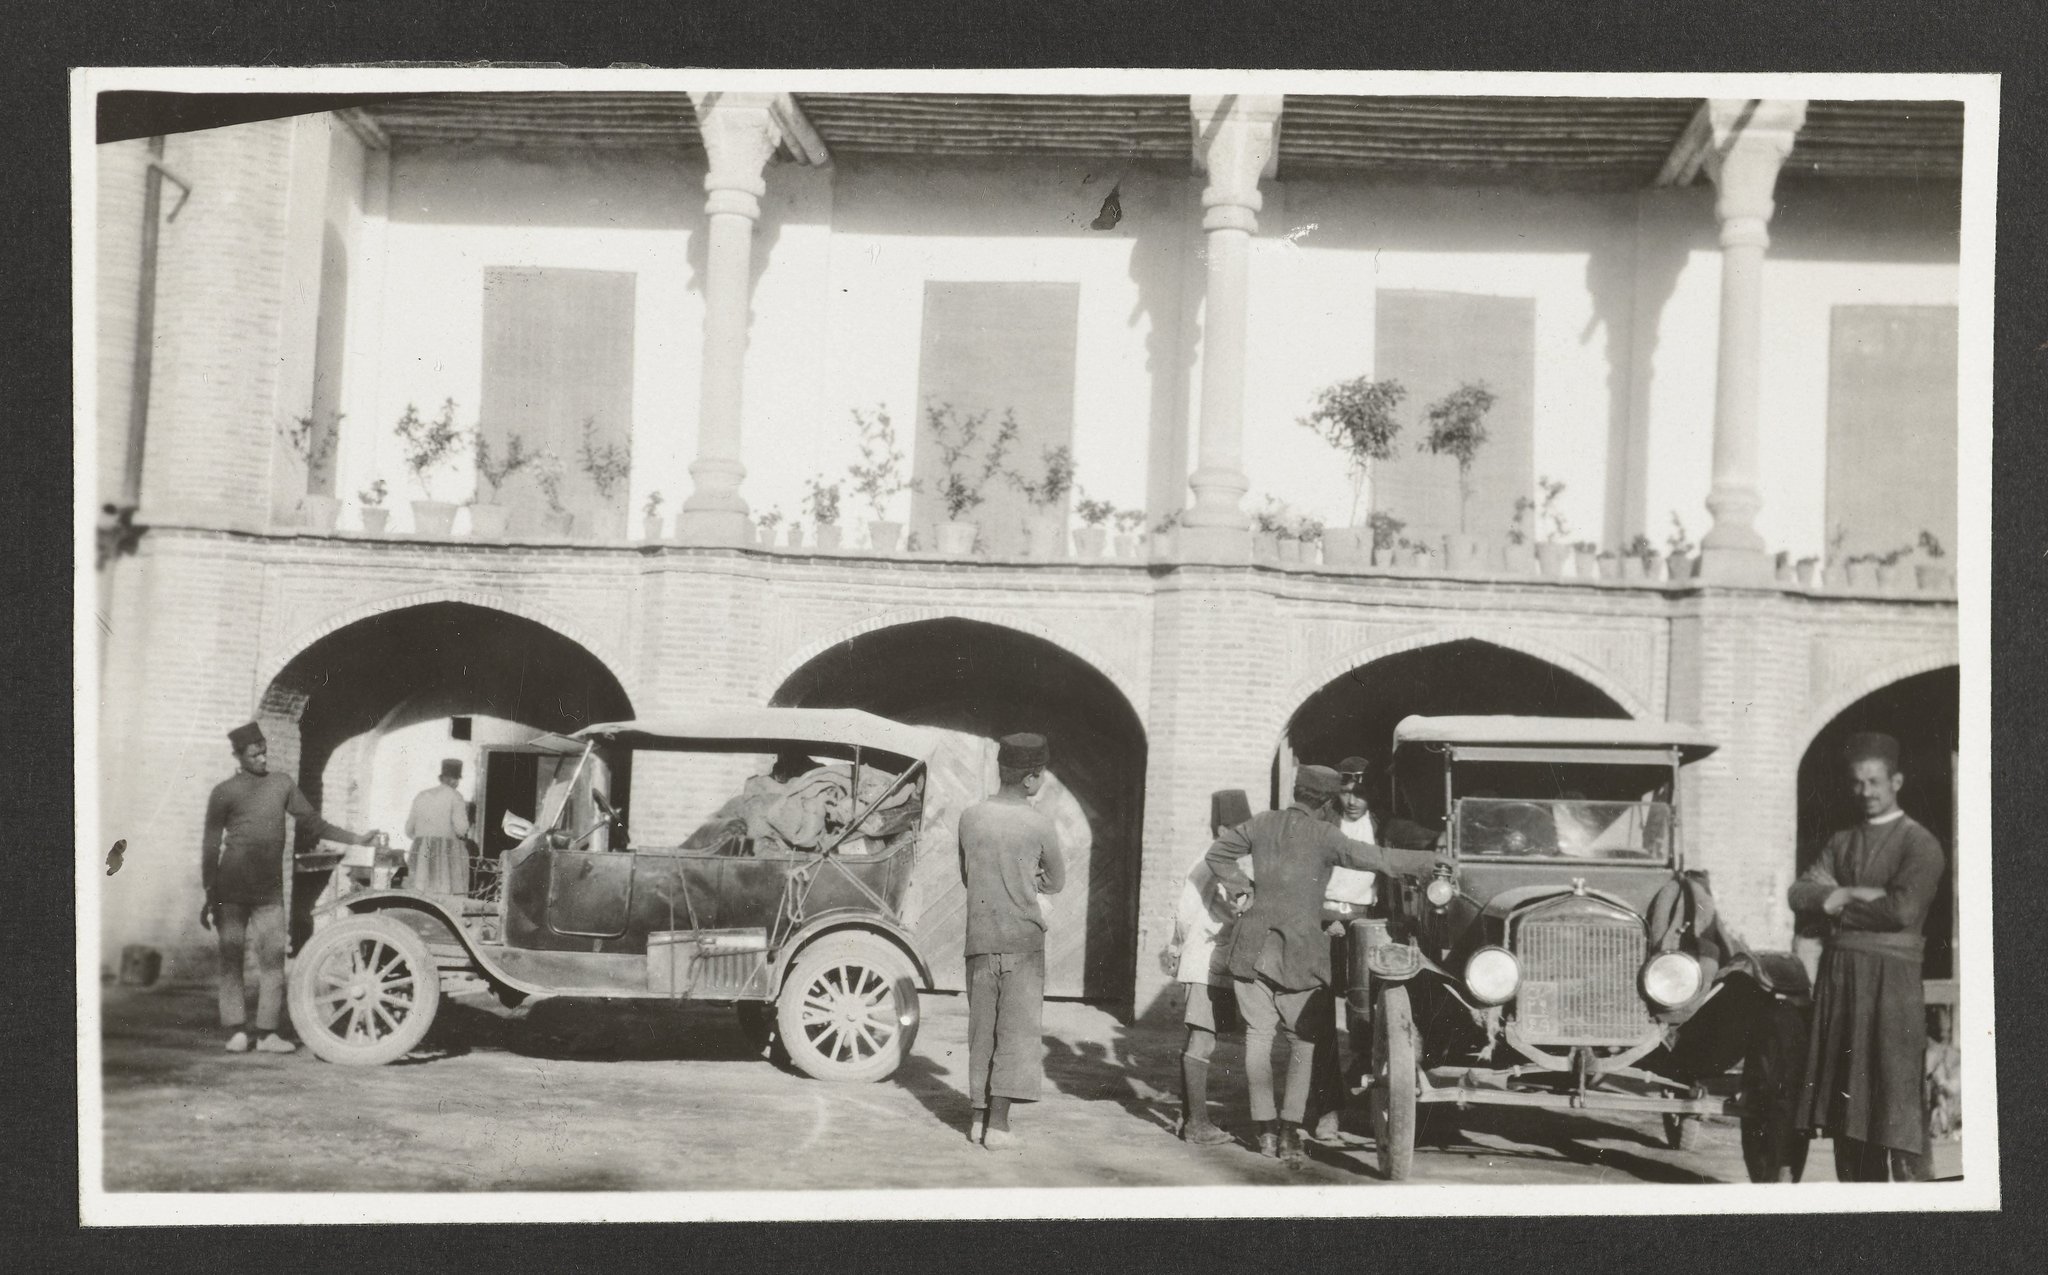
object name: photograph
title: Binnenplaats van het Grand Hotel. Auto's worden gereed gemaakt voor het vertrek.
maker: a.g.a. van eelde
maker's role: engineer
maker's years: 1862-1950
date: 1925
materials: cardboard, paper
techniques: gelatin silver print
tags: iran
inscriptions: number: ‘33.’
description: Titel op object afkomstig uit inventaris (Verklaring der Photo's) behorend bij het album.